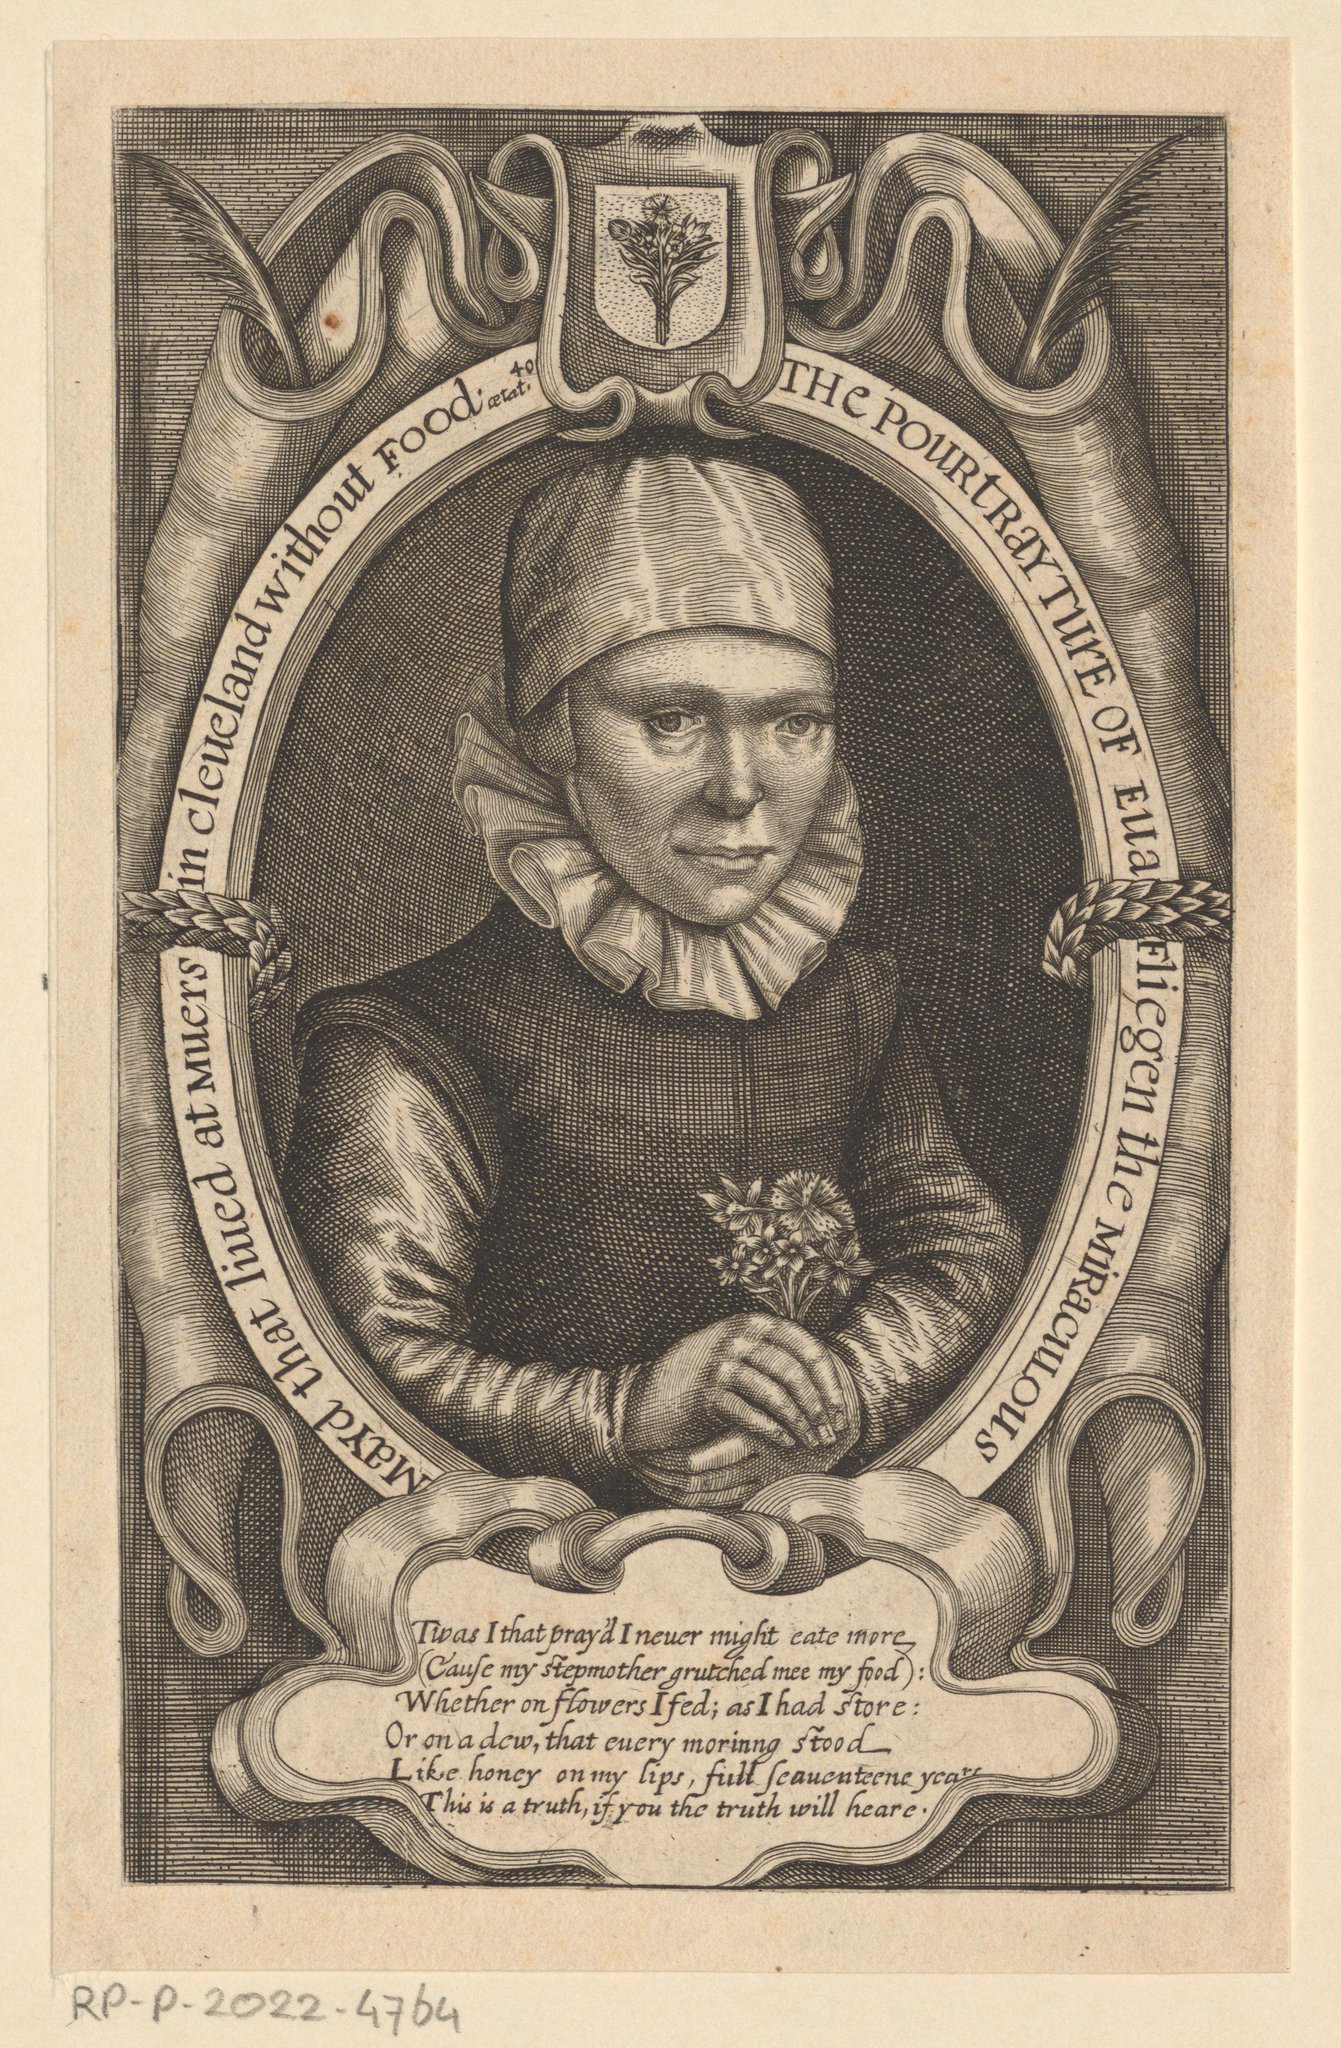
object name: print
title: Portret van Eva Vliegen op 40-jarige leeftijd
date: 1614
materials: paper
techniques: engraving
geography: england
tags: cut flowers; nosegay, bunch of flowers, historical persons - bb - woman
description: Met zesregelig onderschrift in het Engels. De geportretteerde is afgebeeld op het pamflet wegens haar veronderstelde jarenlange onthouding van voedsel. Ze zou zich enkel hebben gevoed met bloemengeur.